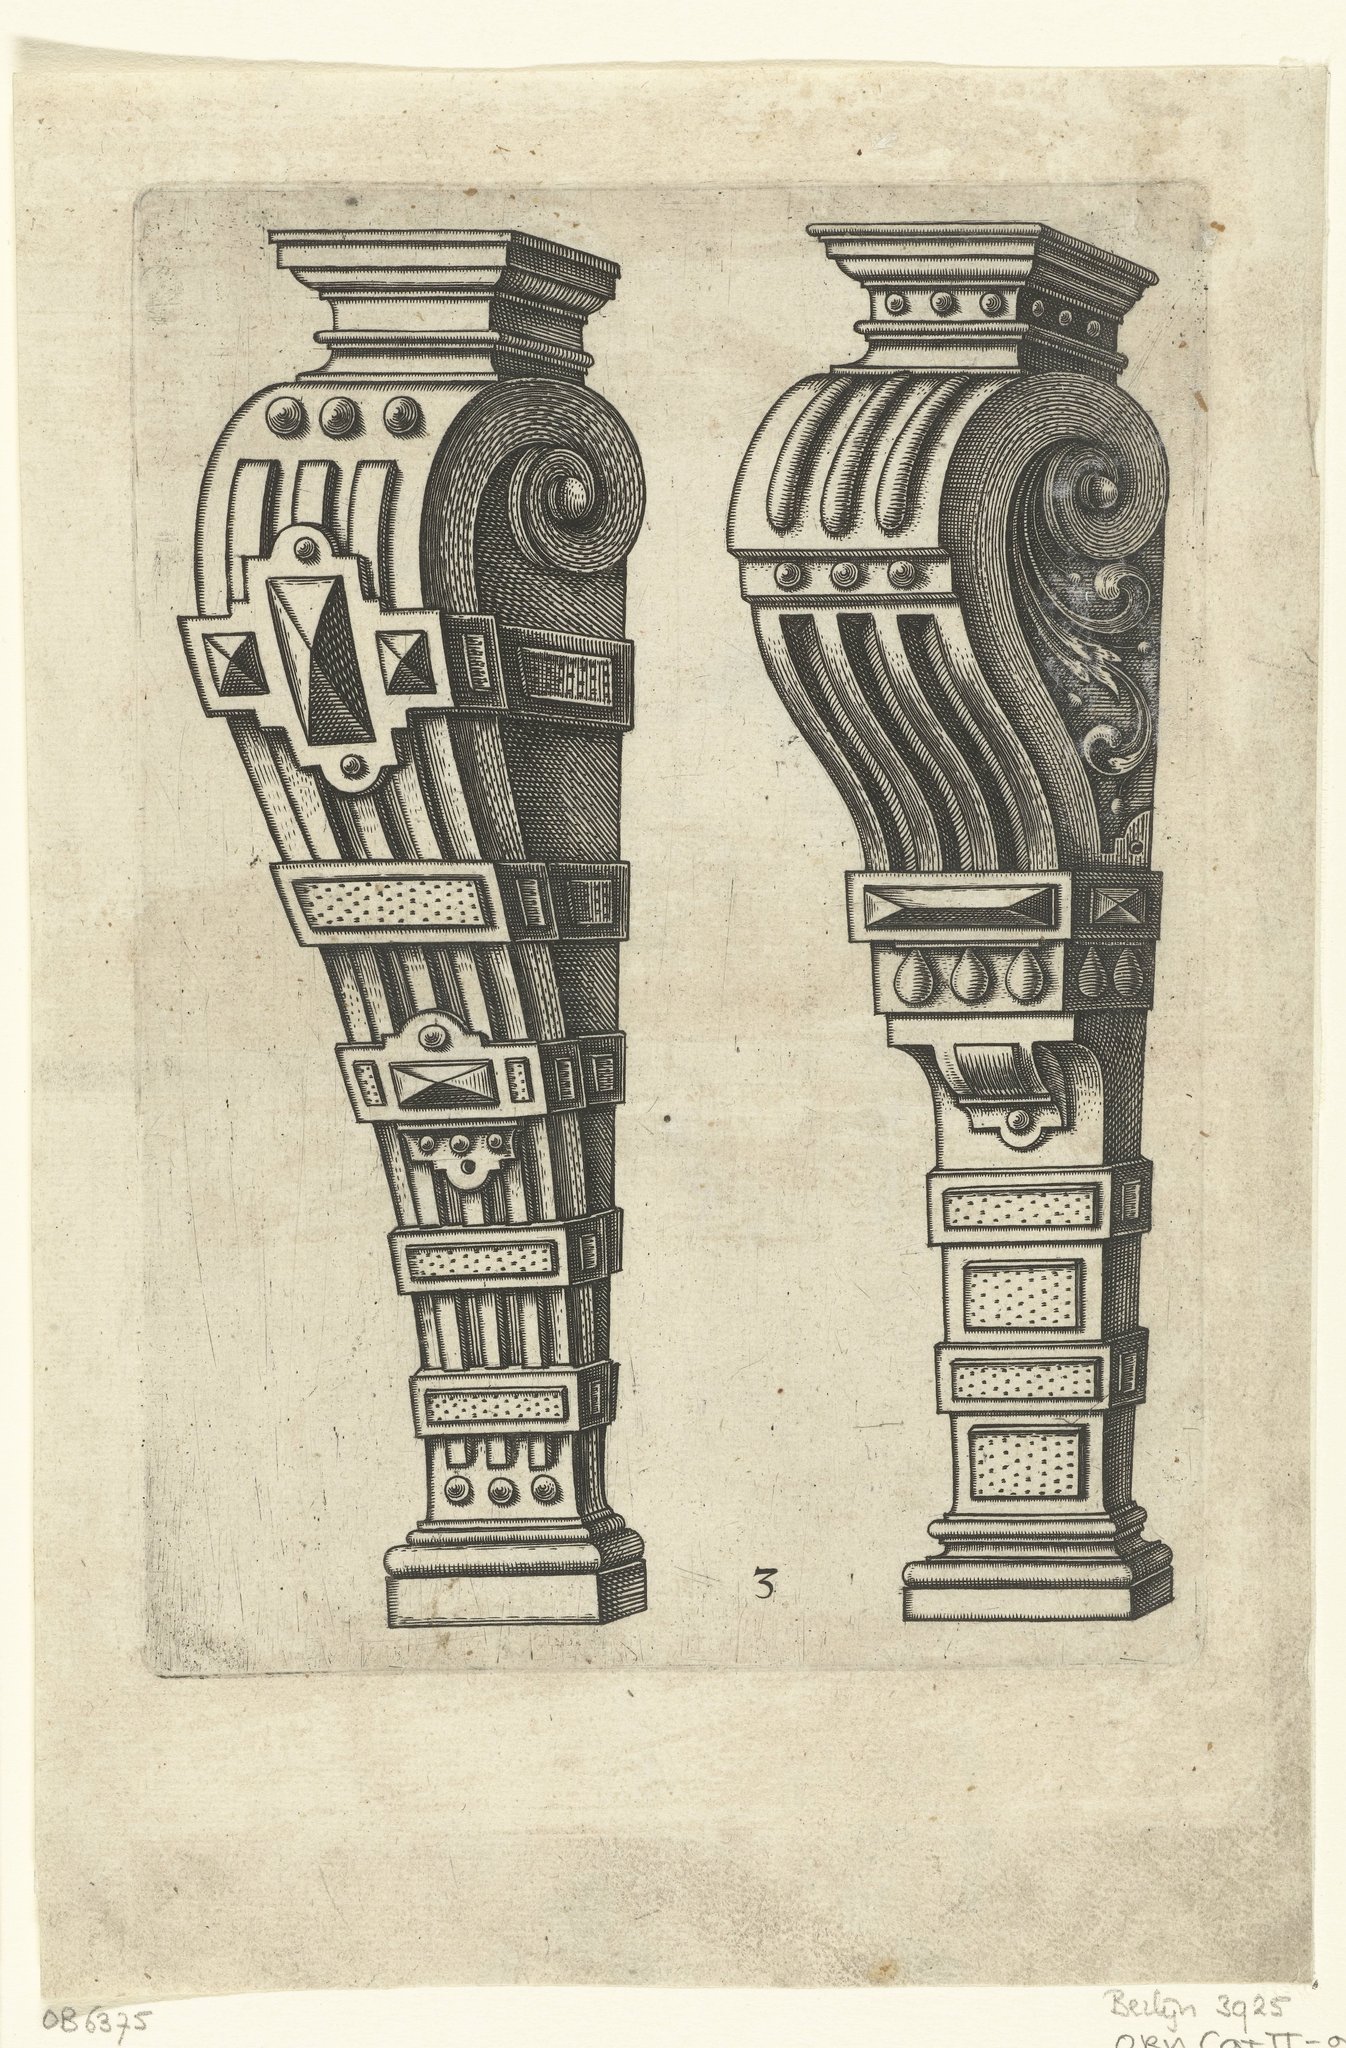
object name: ornament print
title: Etliche zierliche und underscheidliche termen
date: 1604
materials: paper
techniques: engraving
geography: amsterdam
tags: tuscan order ~ architecture